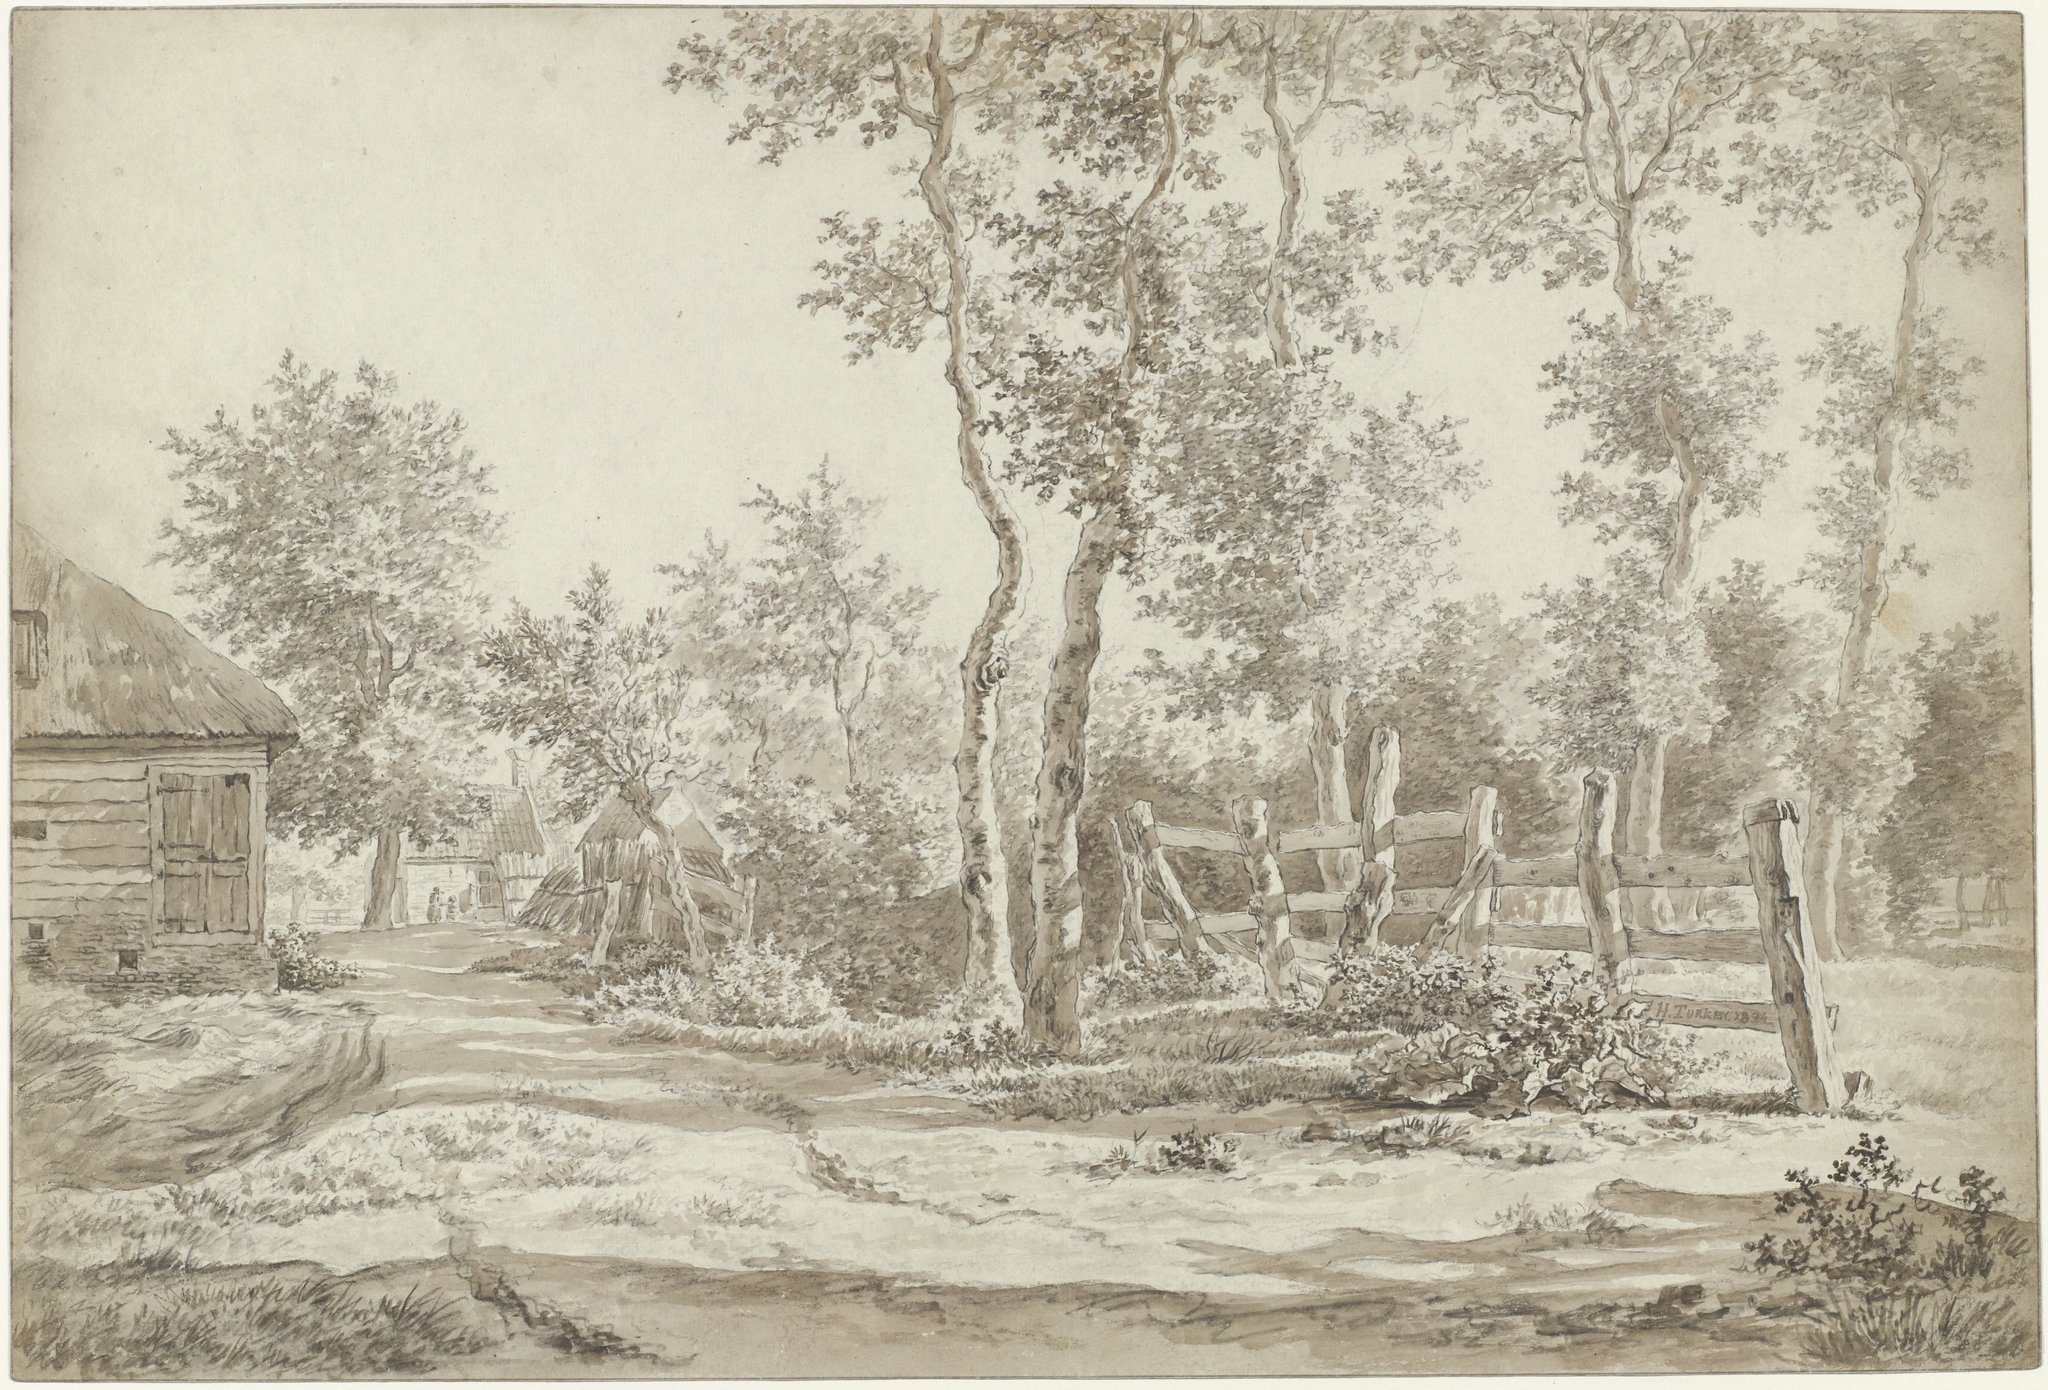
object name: drawing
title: Landschap met bomen, huizen en rechts een hek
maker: henricus turken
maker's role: draughtsman, print maker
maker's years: 1791-1856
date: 1801-1856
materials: chalk, paper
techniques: brush